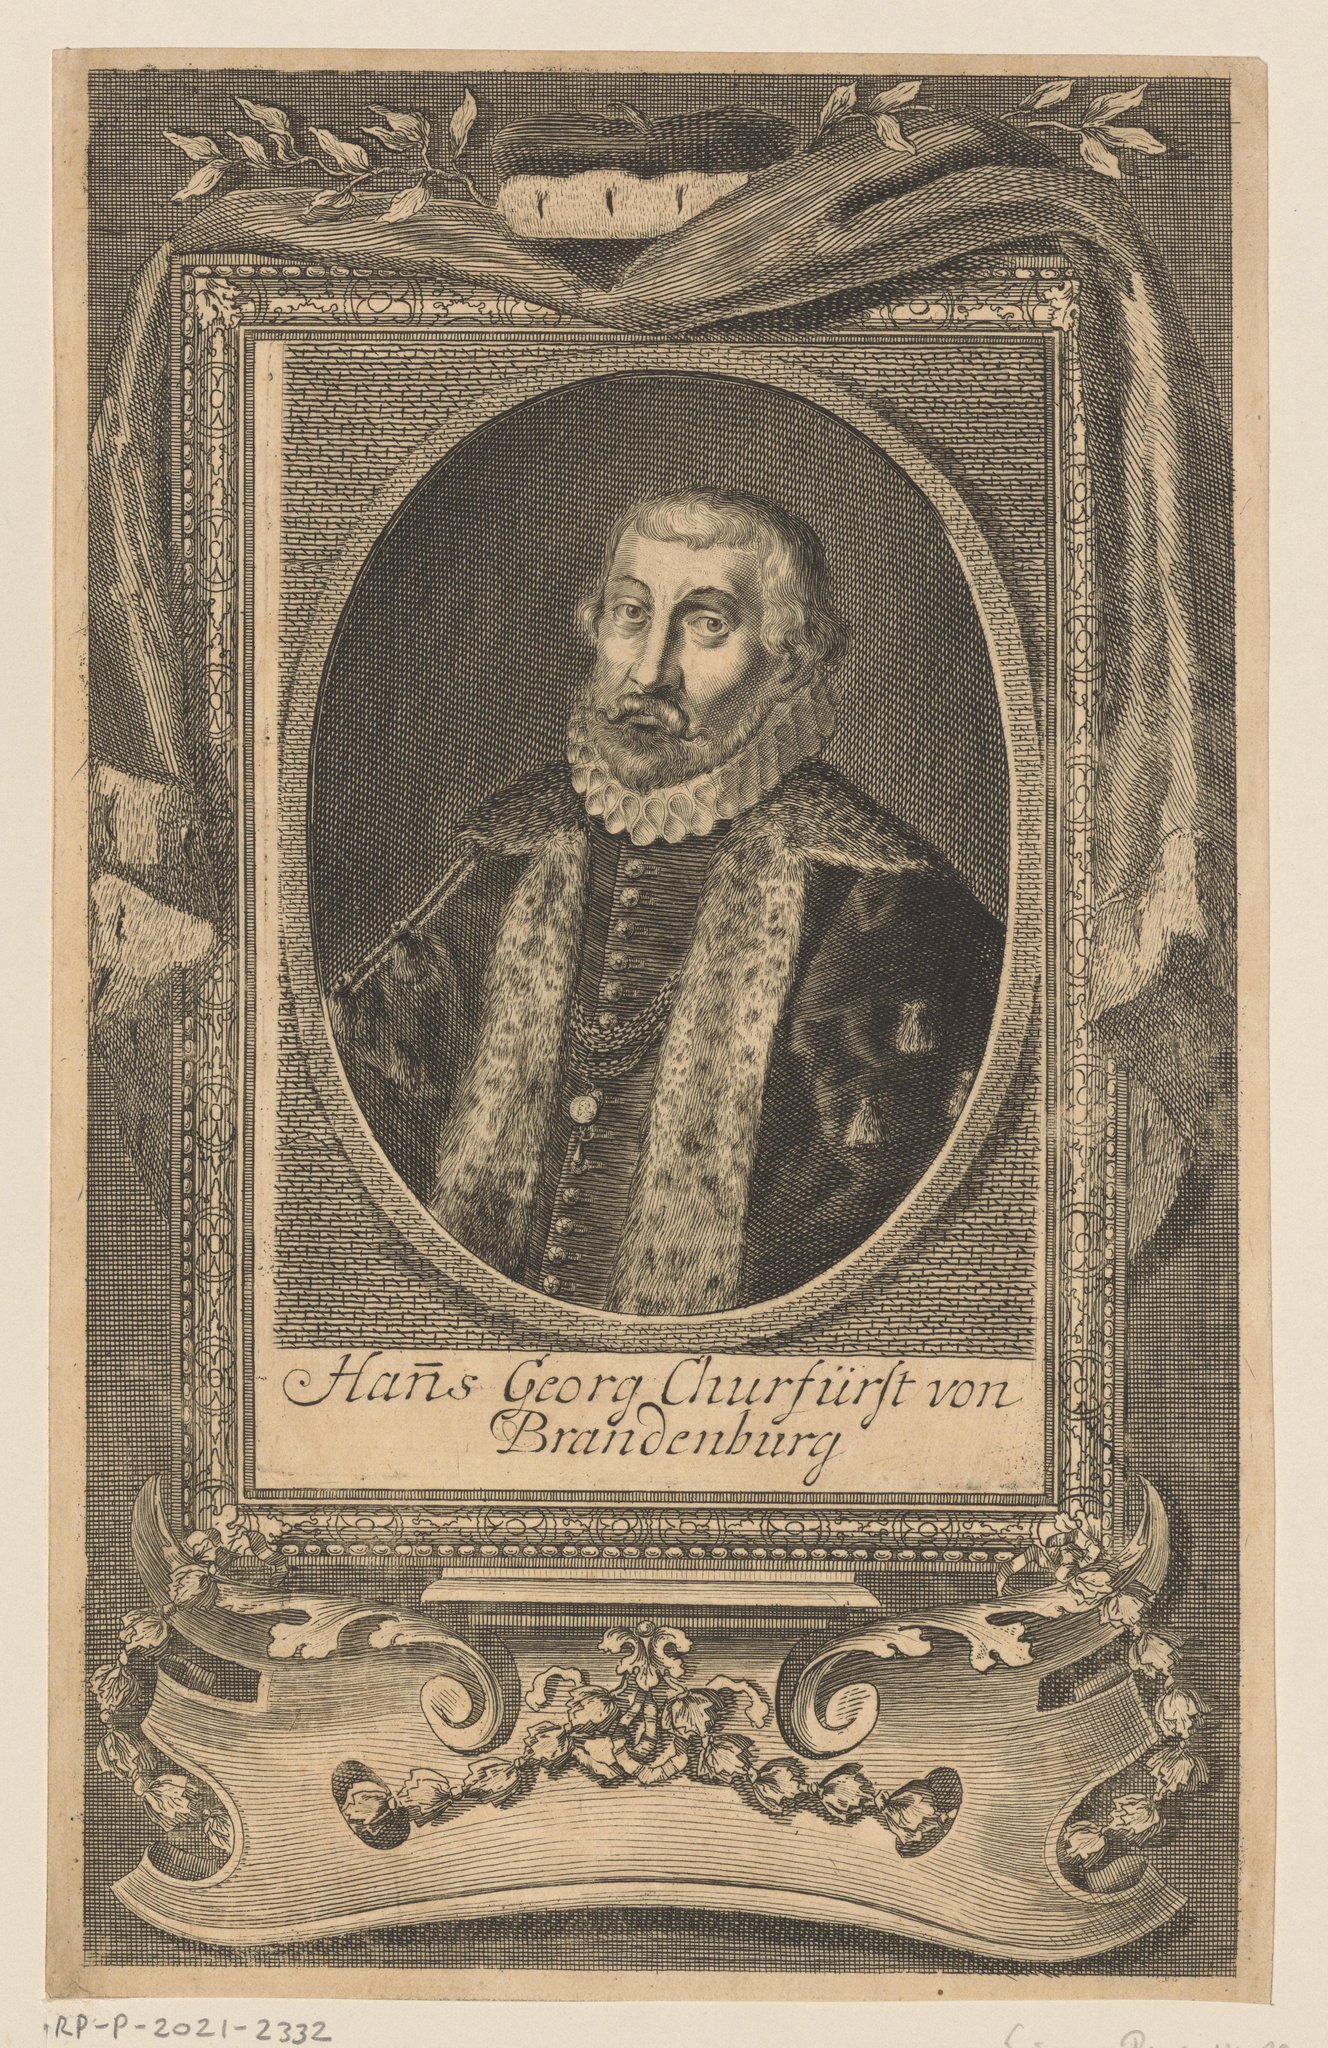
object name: print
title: Hans Georg Churfürst von Brandenburg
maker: Anonymous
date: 1721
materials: paper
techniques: engraving, etching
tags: cologne, historical persons, ruler, sovereign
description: De afgebeelde persoon is Johan Georg van Brandenburg, in plaats van Hans Georg van Brandenburg. Andere staat van prent met andere omlijsting gebruikt in: Khevenhüller, Franz Christoph. Conterfet Kupferstich (so viel man bekommen können) deren jenigen vornehmen Ministren un hohen Officiern (...). 2 dln. Leipzig: Moritz Georg Weidmann, 1721, dl. 1. Omlijsting is bij andere portretten uit dit boek gebruikt.